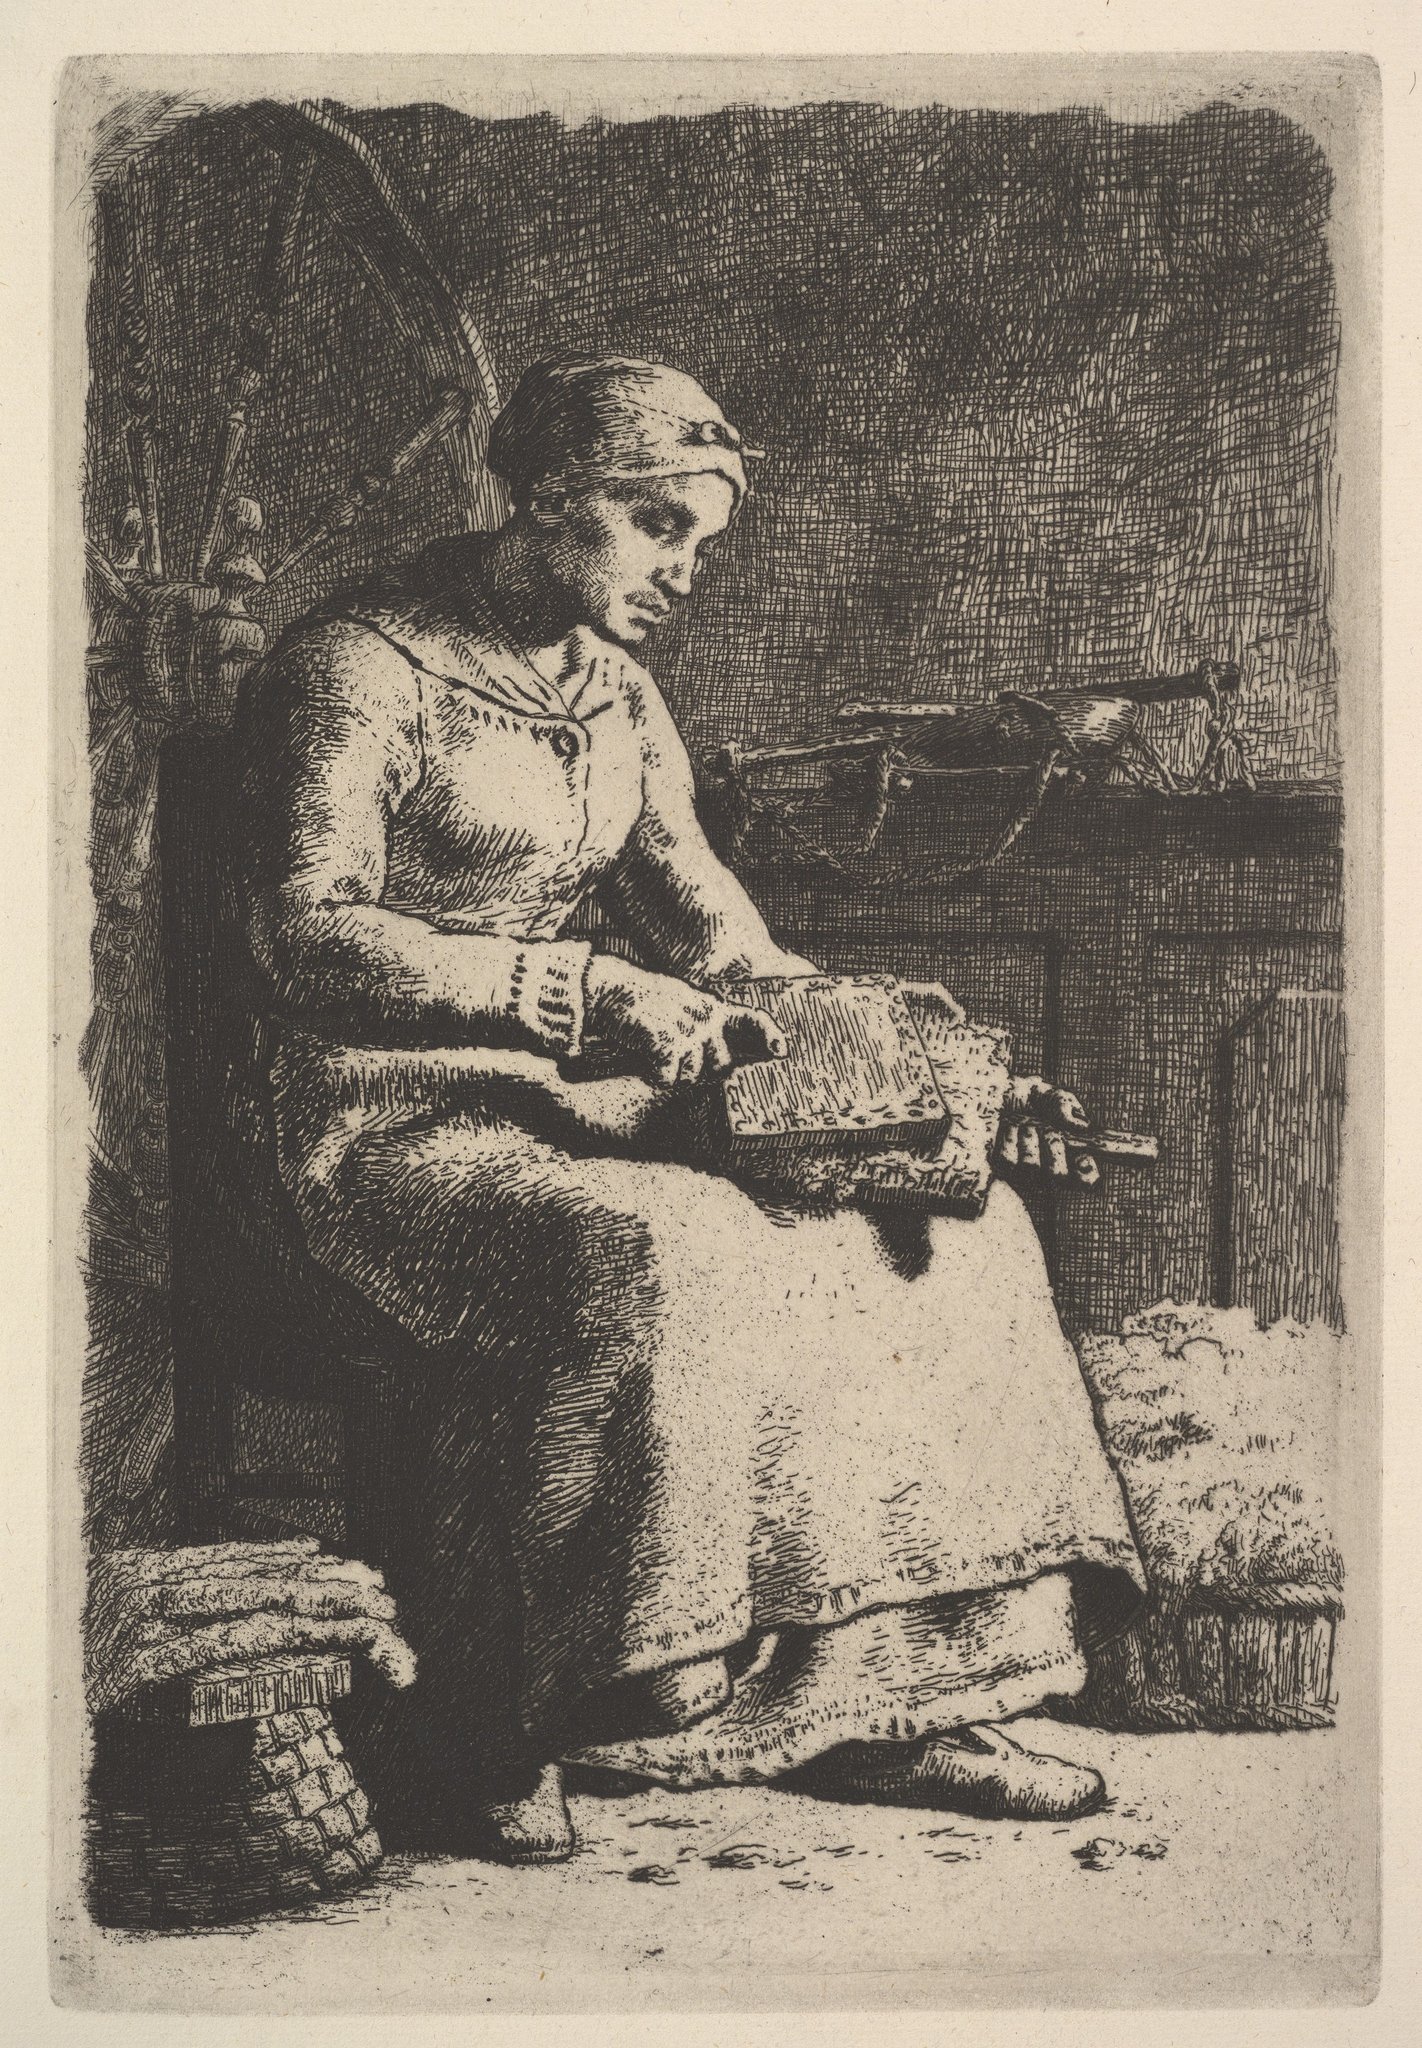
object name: print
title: The Wool Carder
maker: jean-françois millet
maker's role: artist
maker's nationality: french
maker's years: 1814-1875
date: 1855-1856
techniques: etching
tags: women,working